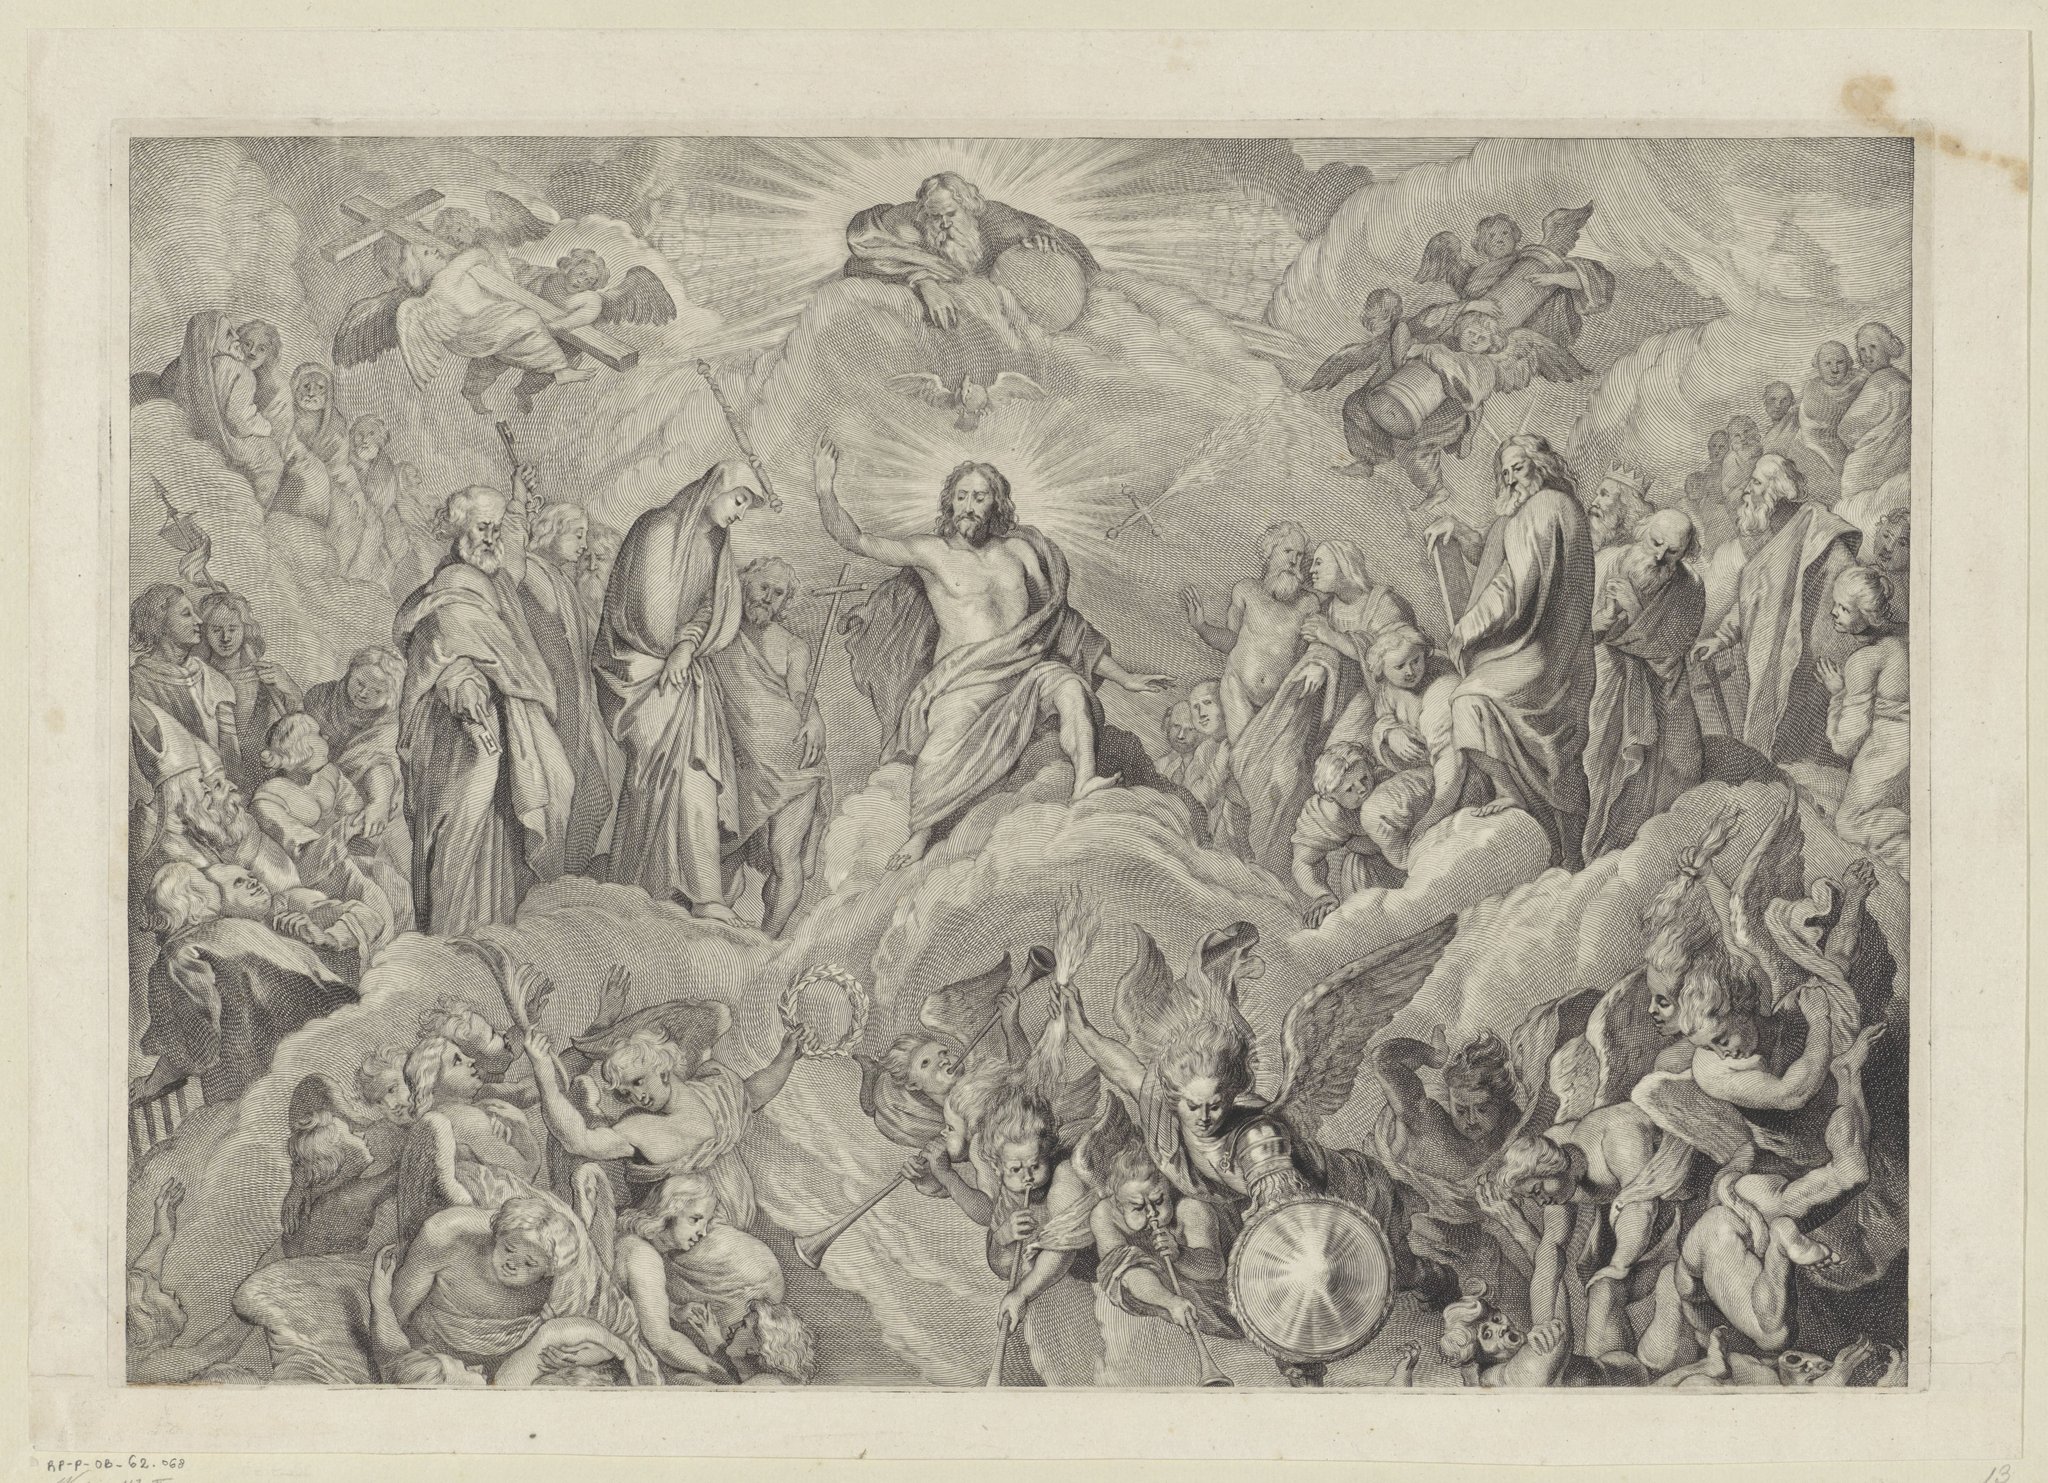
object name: print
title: Laatste Oordeel (bovenste plaat)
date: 1644-1650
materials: paper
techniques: engraving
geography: haarlem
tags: last judgement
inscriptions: collector's mark: Lugt 240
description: Christus zit tronend als rechter op een wolk in de hemel bij het Laatste oordeel. Hij maakt een spreekgebaar en wordt omringd door engelen, koningen, kerkvaders en zijn apostelen. Boven hem vliegt een duif en ligt God met de wereldbol op een wolk.